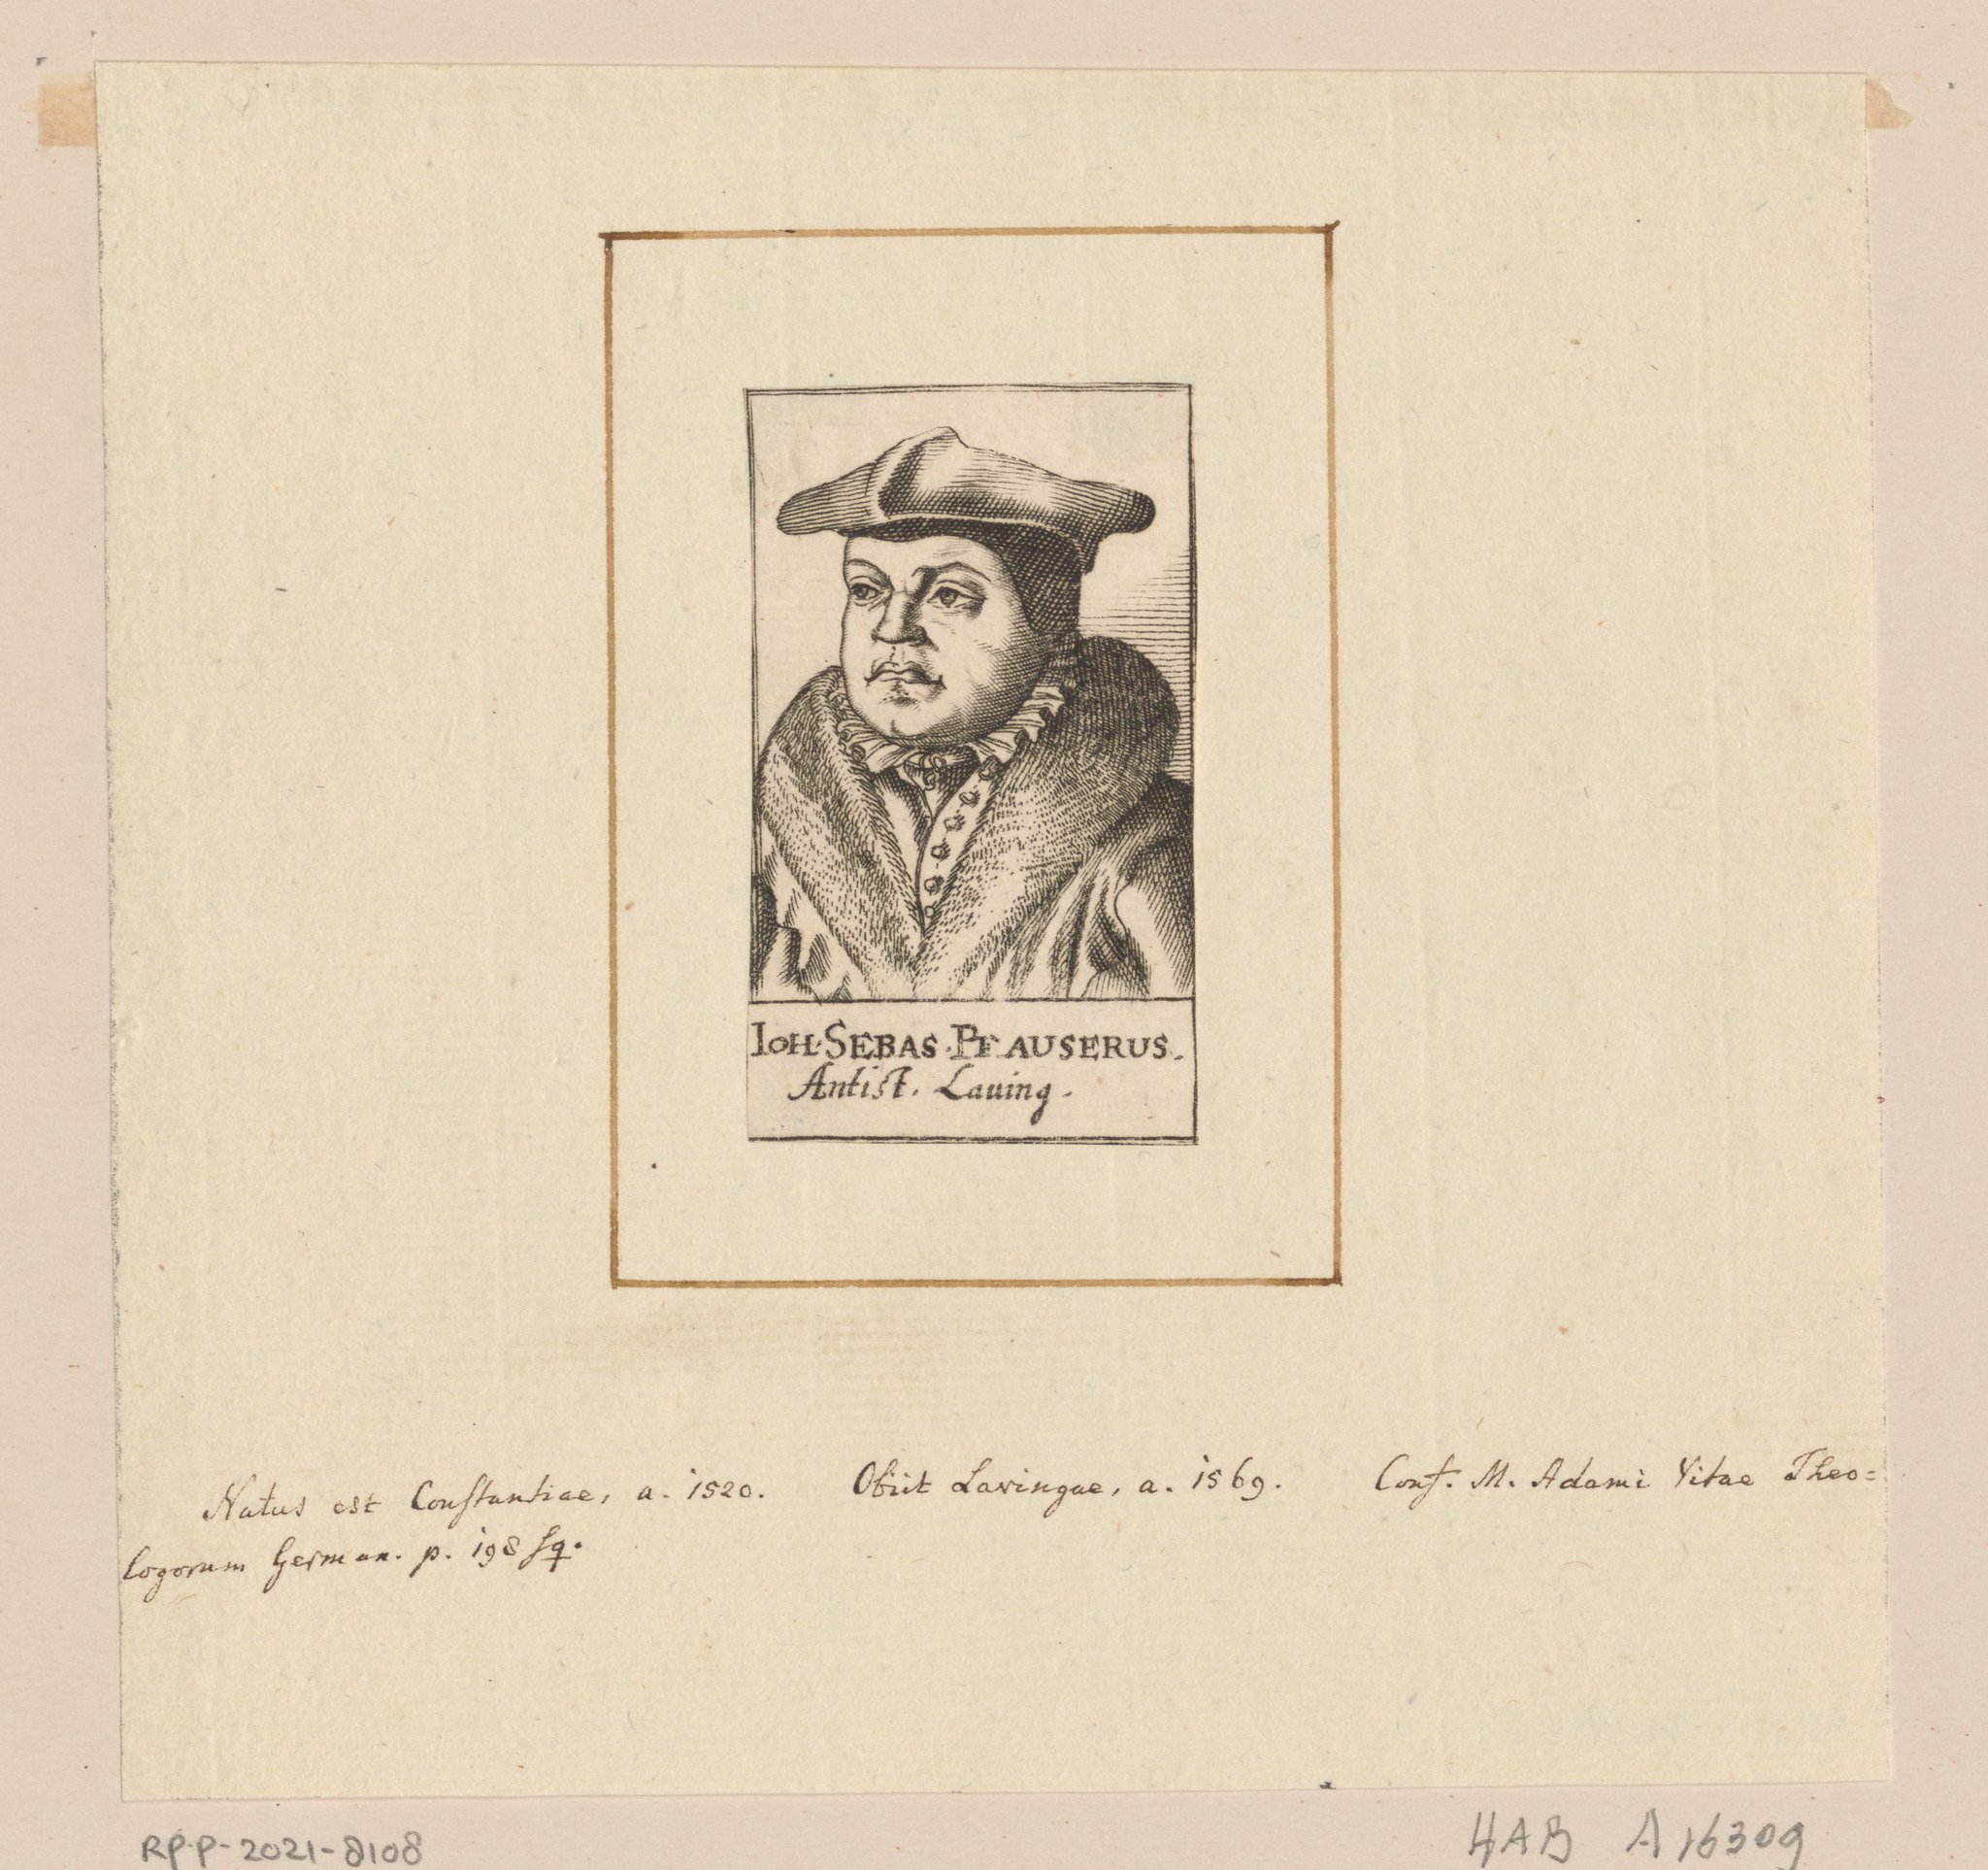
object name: book illustration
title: Portret van Johann Sebastian Pfauser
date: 1688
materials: paper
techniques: engraving, etching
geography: nuremberg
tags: adult man, historical persons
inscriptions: inscription: ‘Natus est (...) p. 198 fq.’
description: Prent maakt deel uit van een grotere prent die later is verknipt. Prent uit: Freher, Paul. Theatrum virorum eruditione clarorum. Neurenberg: Johann Hoffmann, 1688.